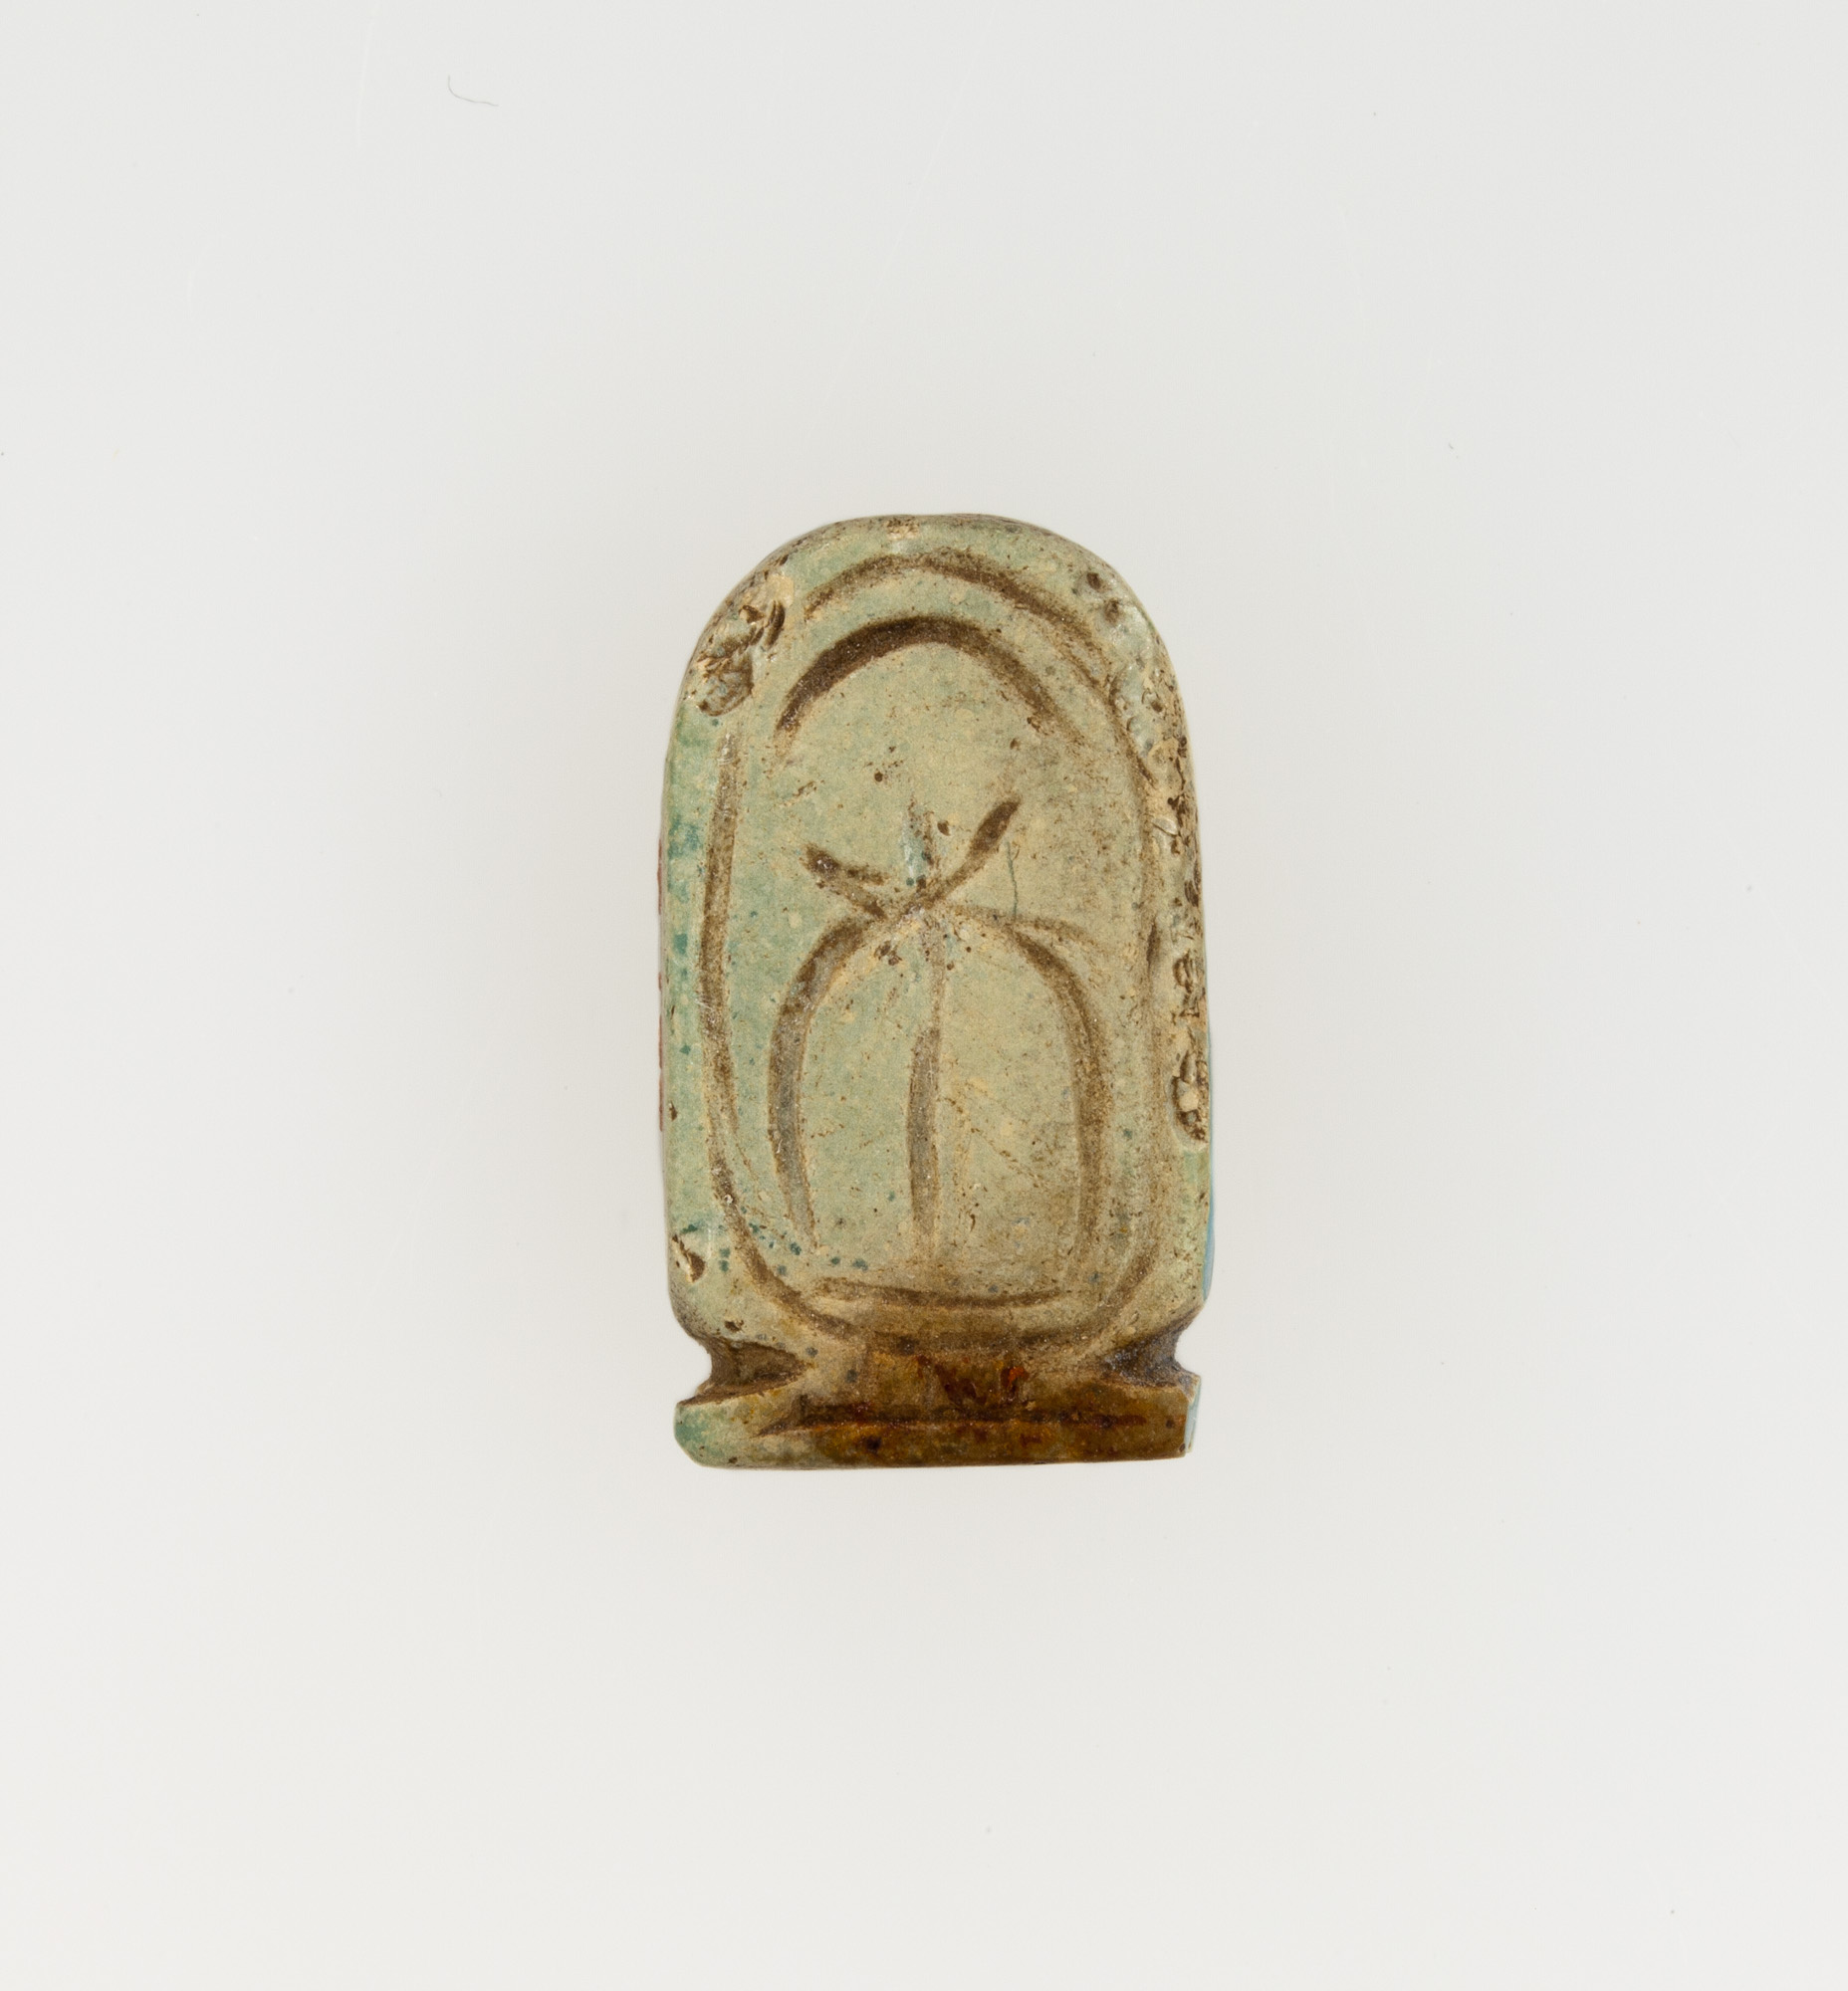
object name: plaque, ahmose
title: Plaque Inscribed with the Name Ahmose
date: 1550-1525 BCE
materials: stone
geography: egypt